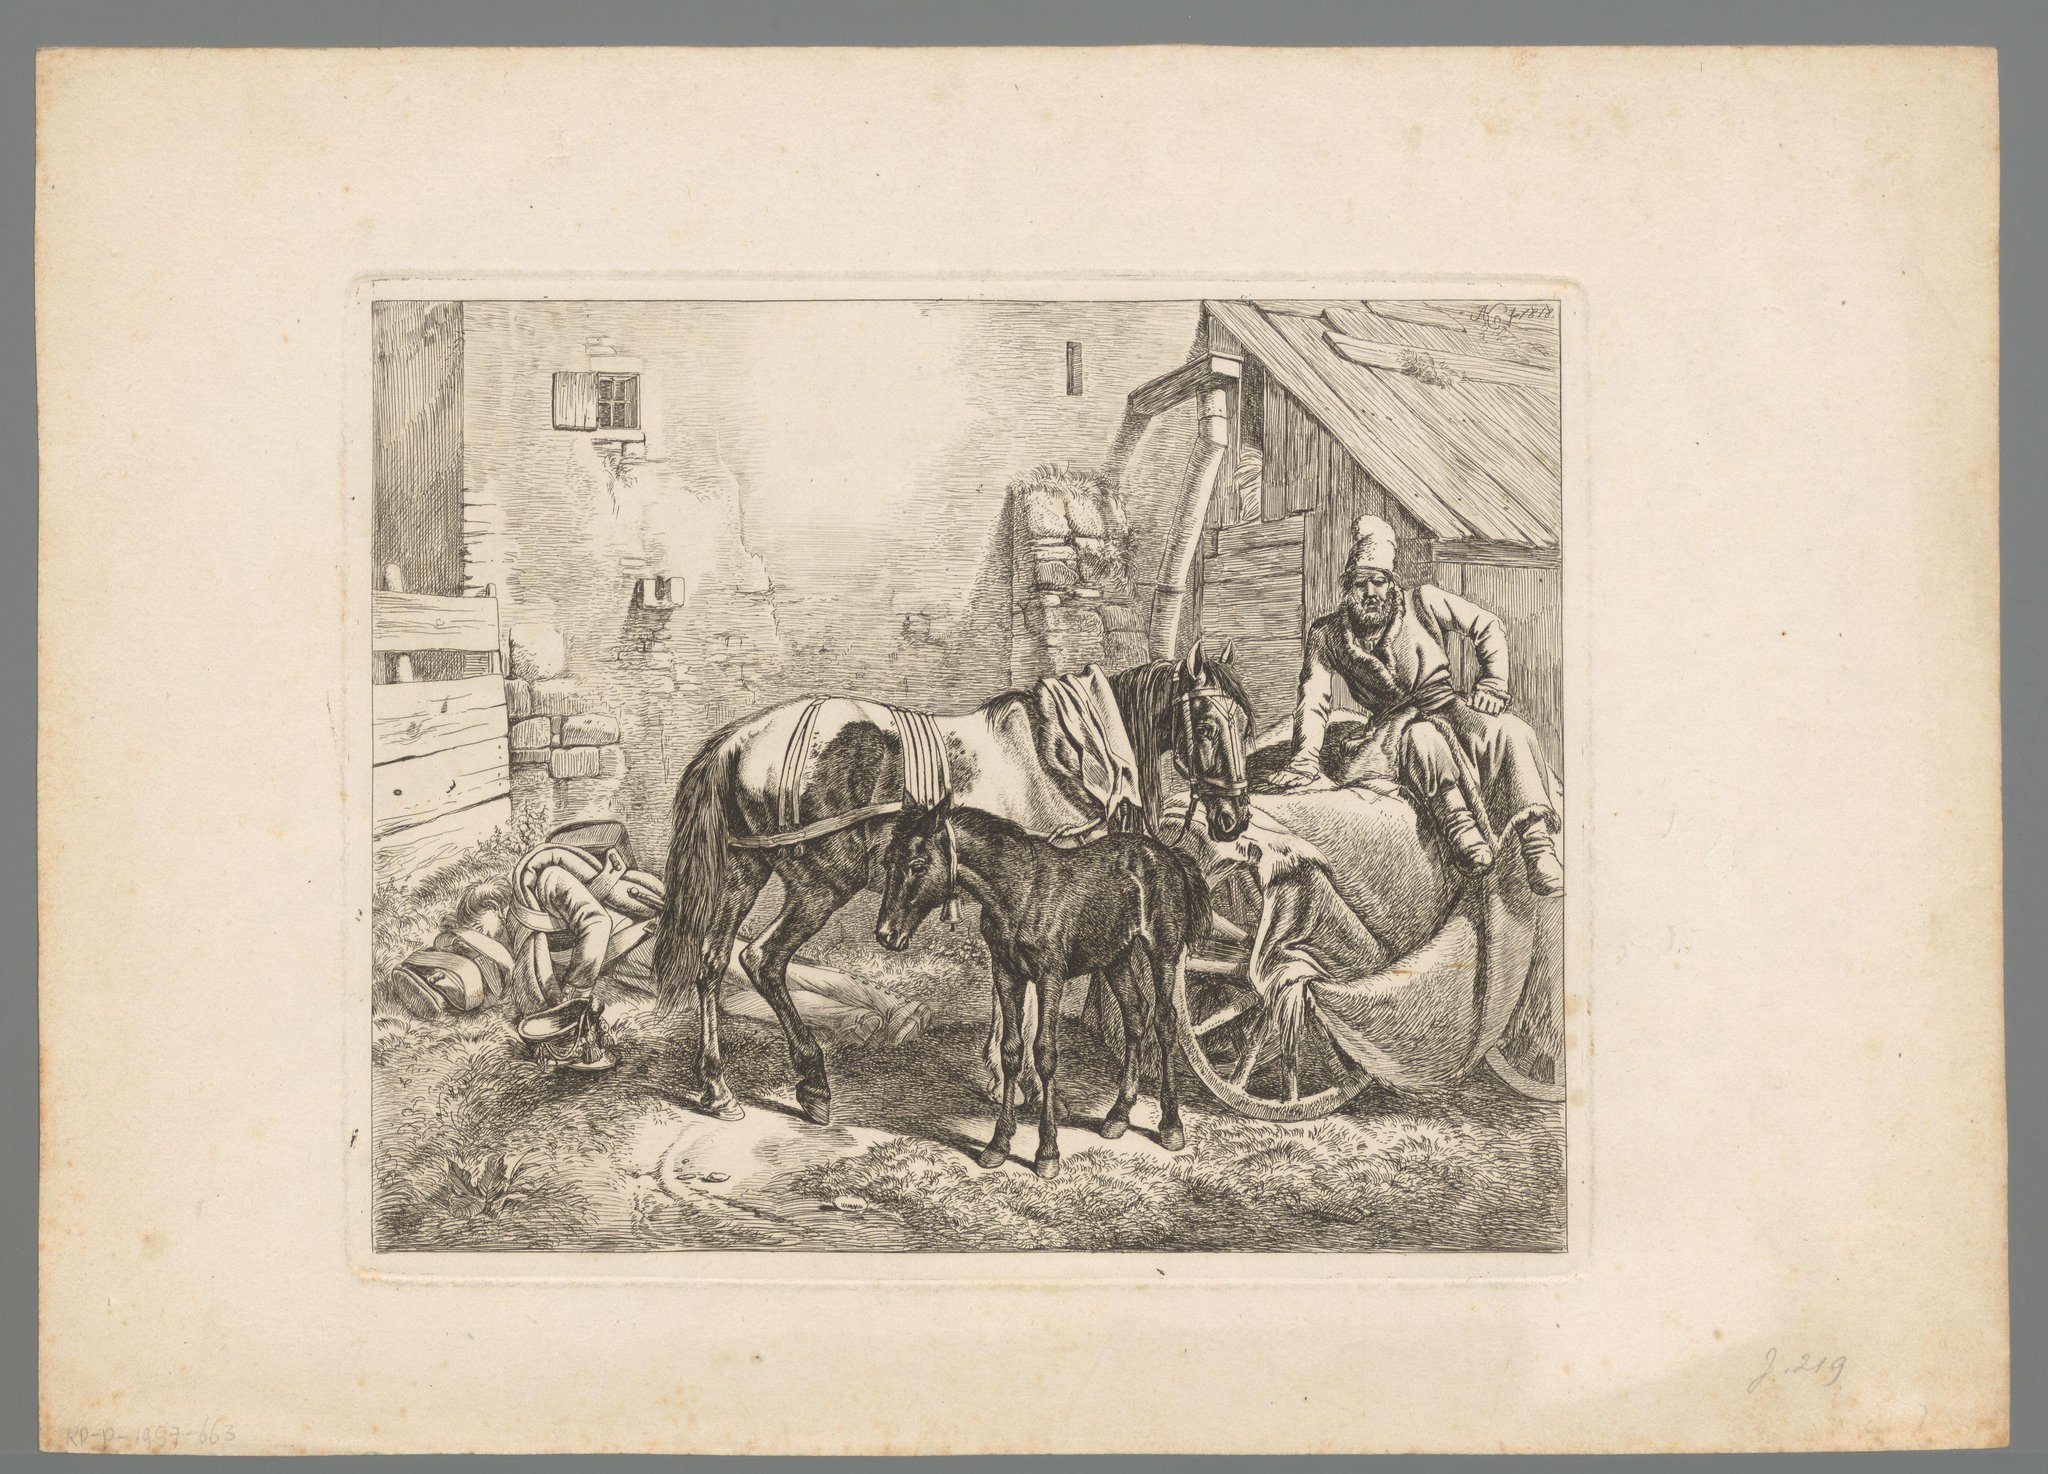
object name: print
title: Ide Suite de Six Sujets Militaires dessinés d'apres nature et gravées a l'eau forte par J.A. Klein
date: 1818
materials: paper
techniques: etching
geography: mannheim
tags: horse, (farm) wagon, freight wagon, cart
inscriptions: collector's mark: Lugt 2760, collector's mark: Lugt 2228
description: Deze prent maakt deel uit van een omslag met zes prenten.